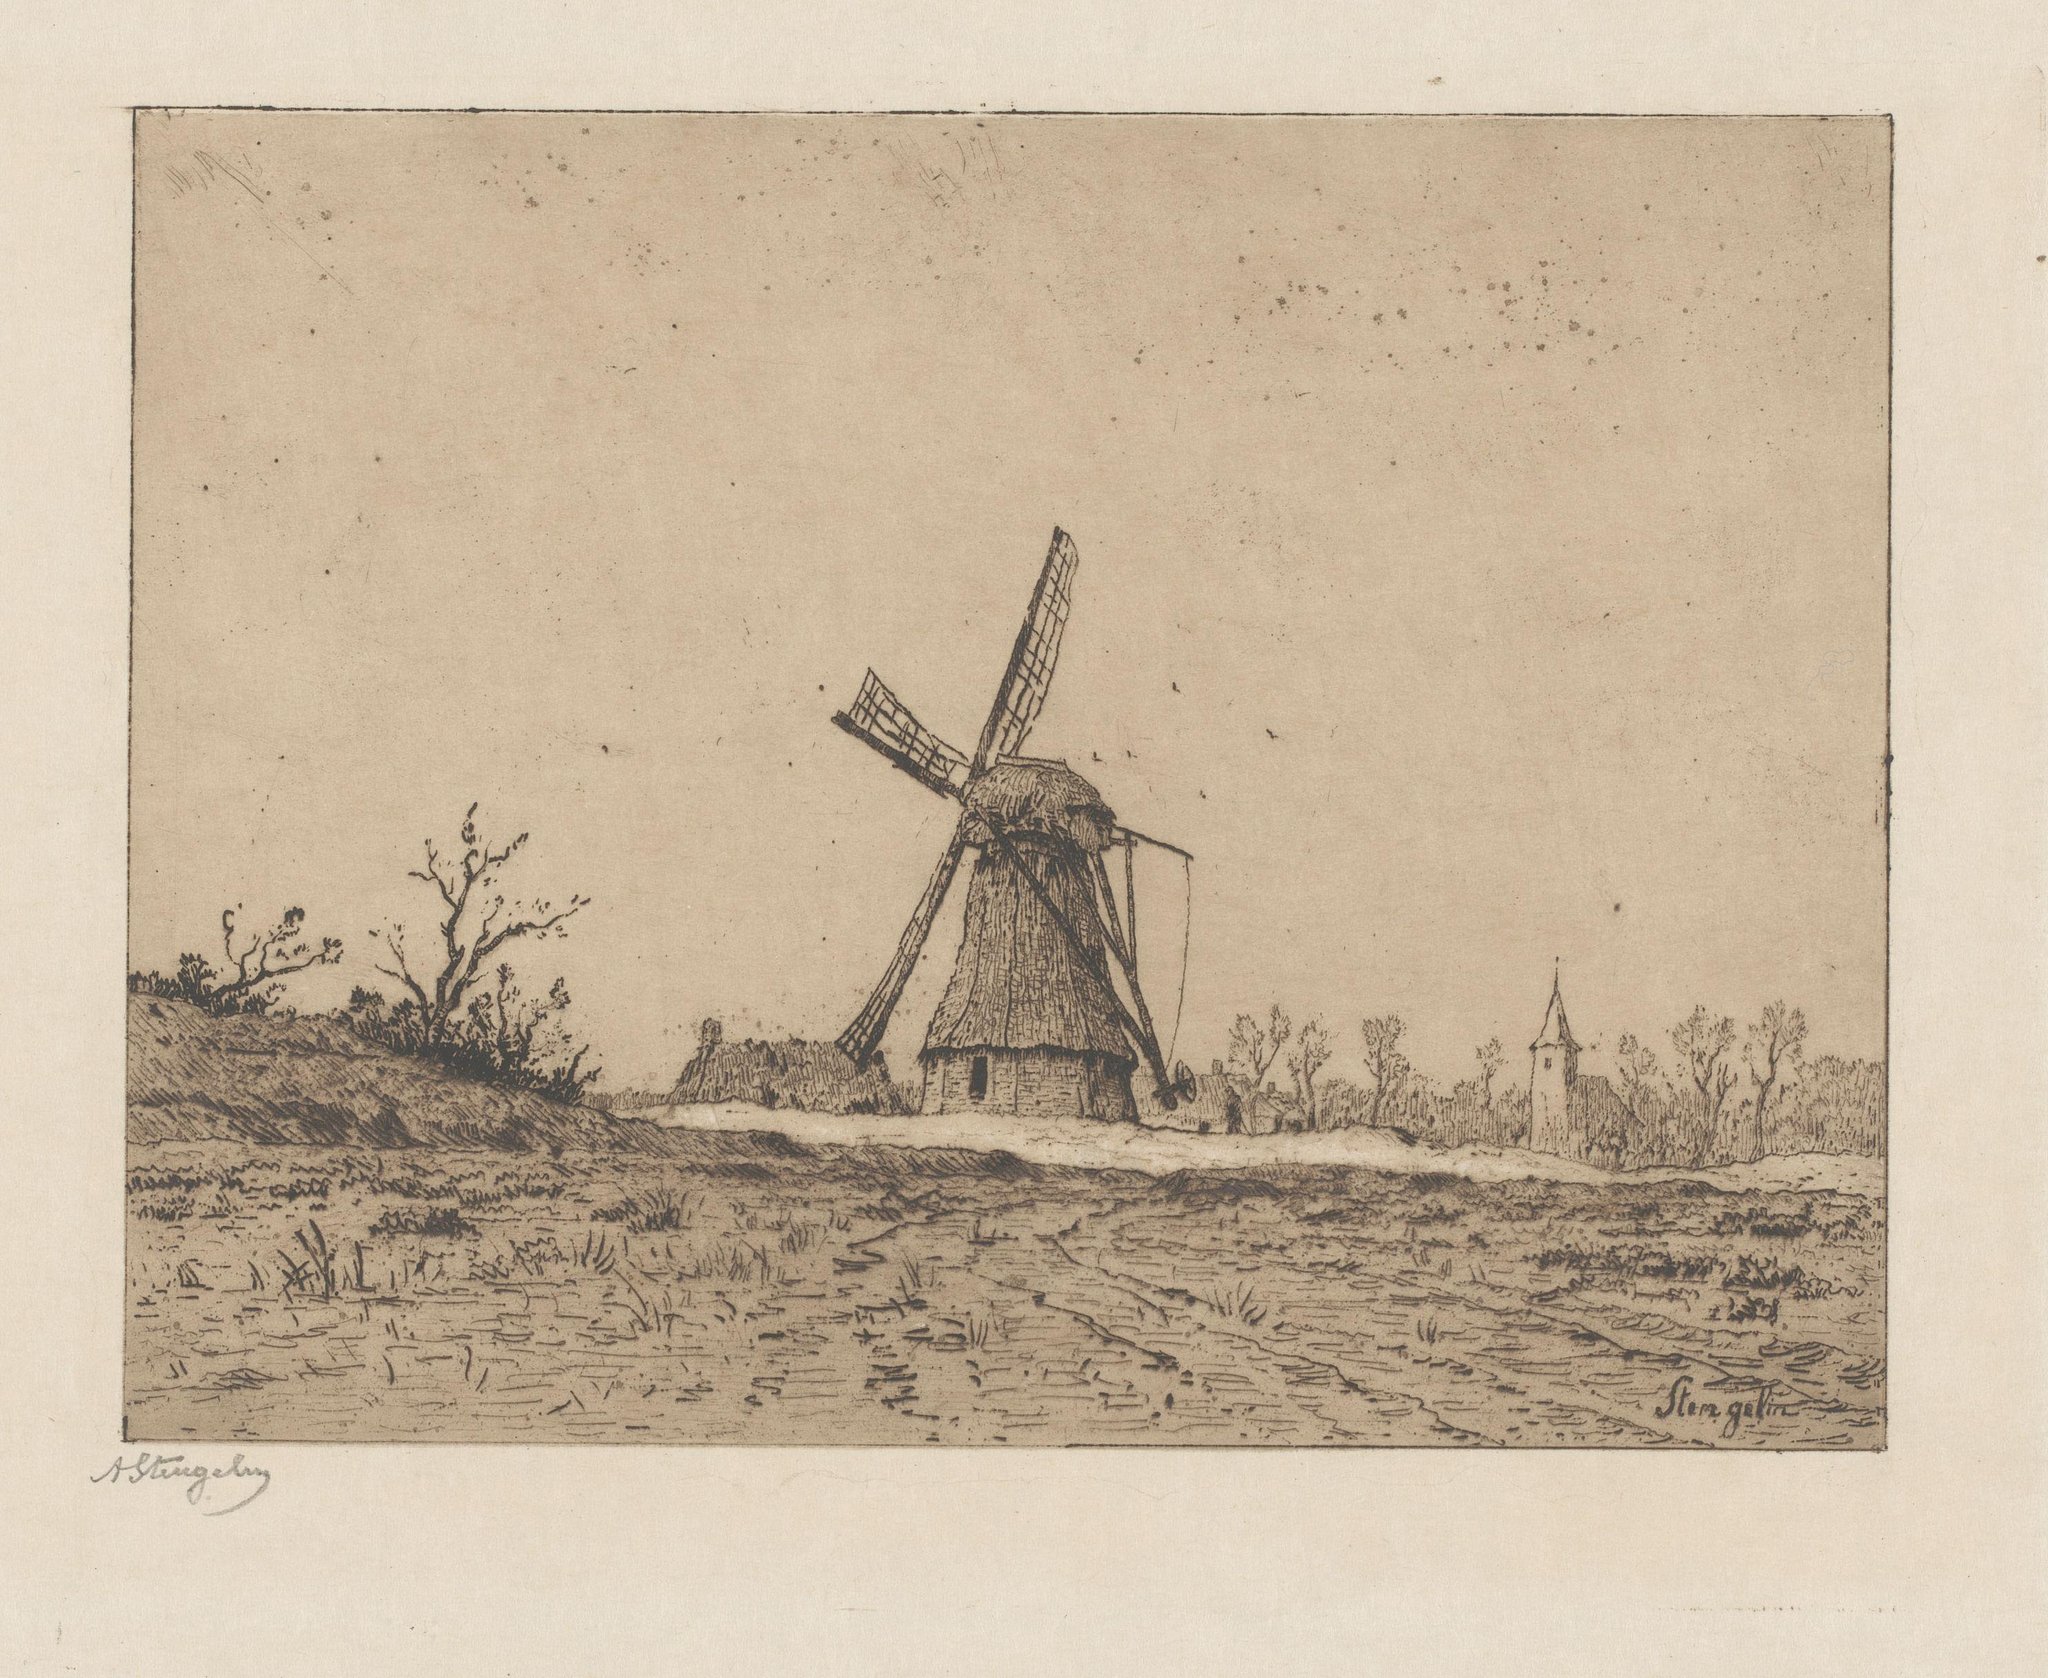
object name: print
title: Molen te Westerbork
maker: alphonse stengelin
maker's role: painter, print maker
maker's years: 1852-1938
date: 1862-1913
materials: paper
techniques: etching, intaglio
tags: windmill in landscape, windmill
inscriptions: collector's mark: Lugt 2233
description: Twee drukken in collectie Rijksmuseum, waarvan RP-P-1913-6071 in bruin en RP-P-1910-339 in zwart.